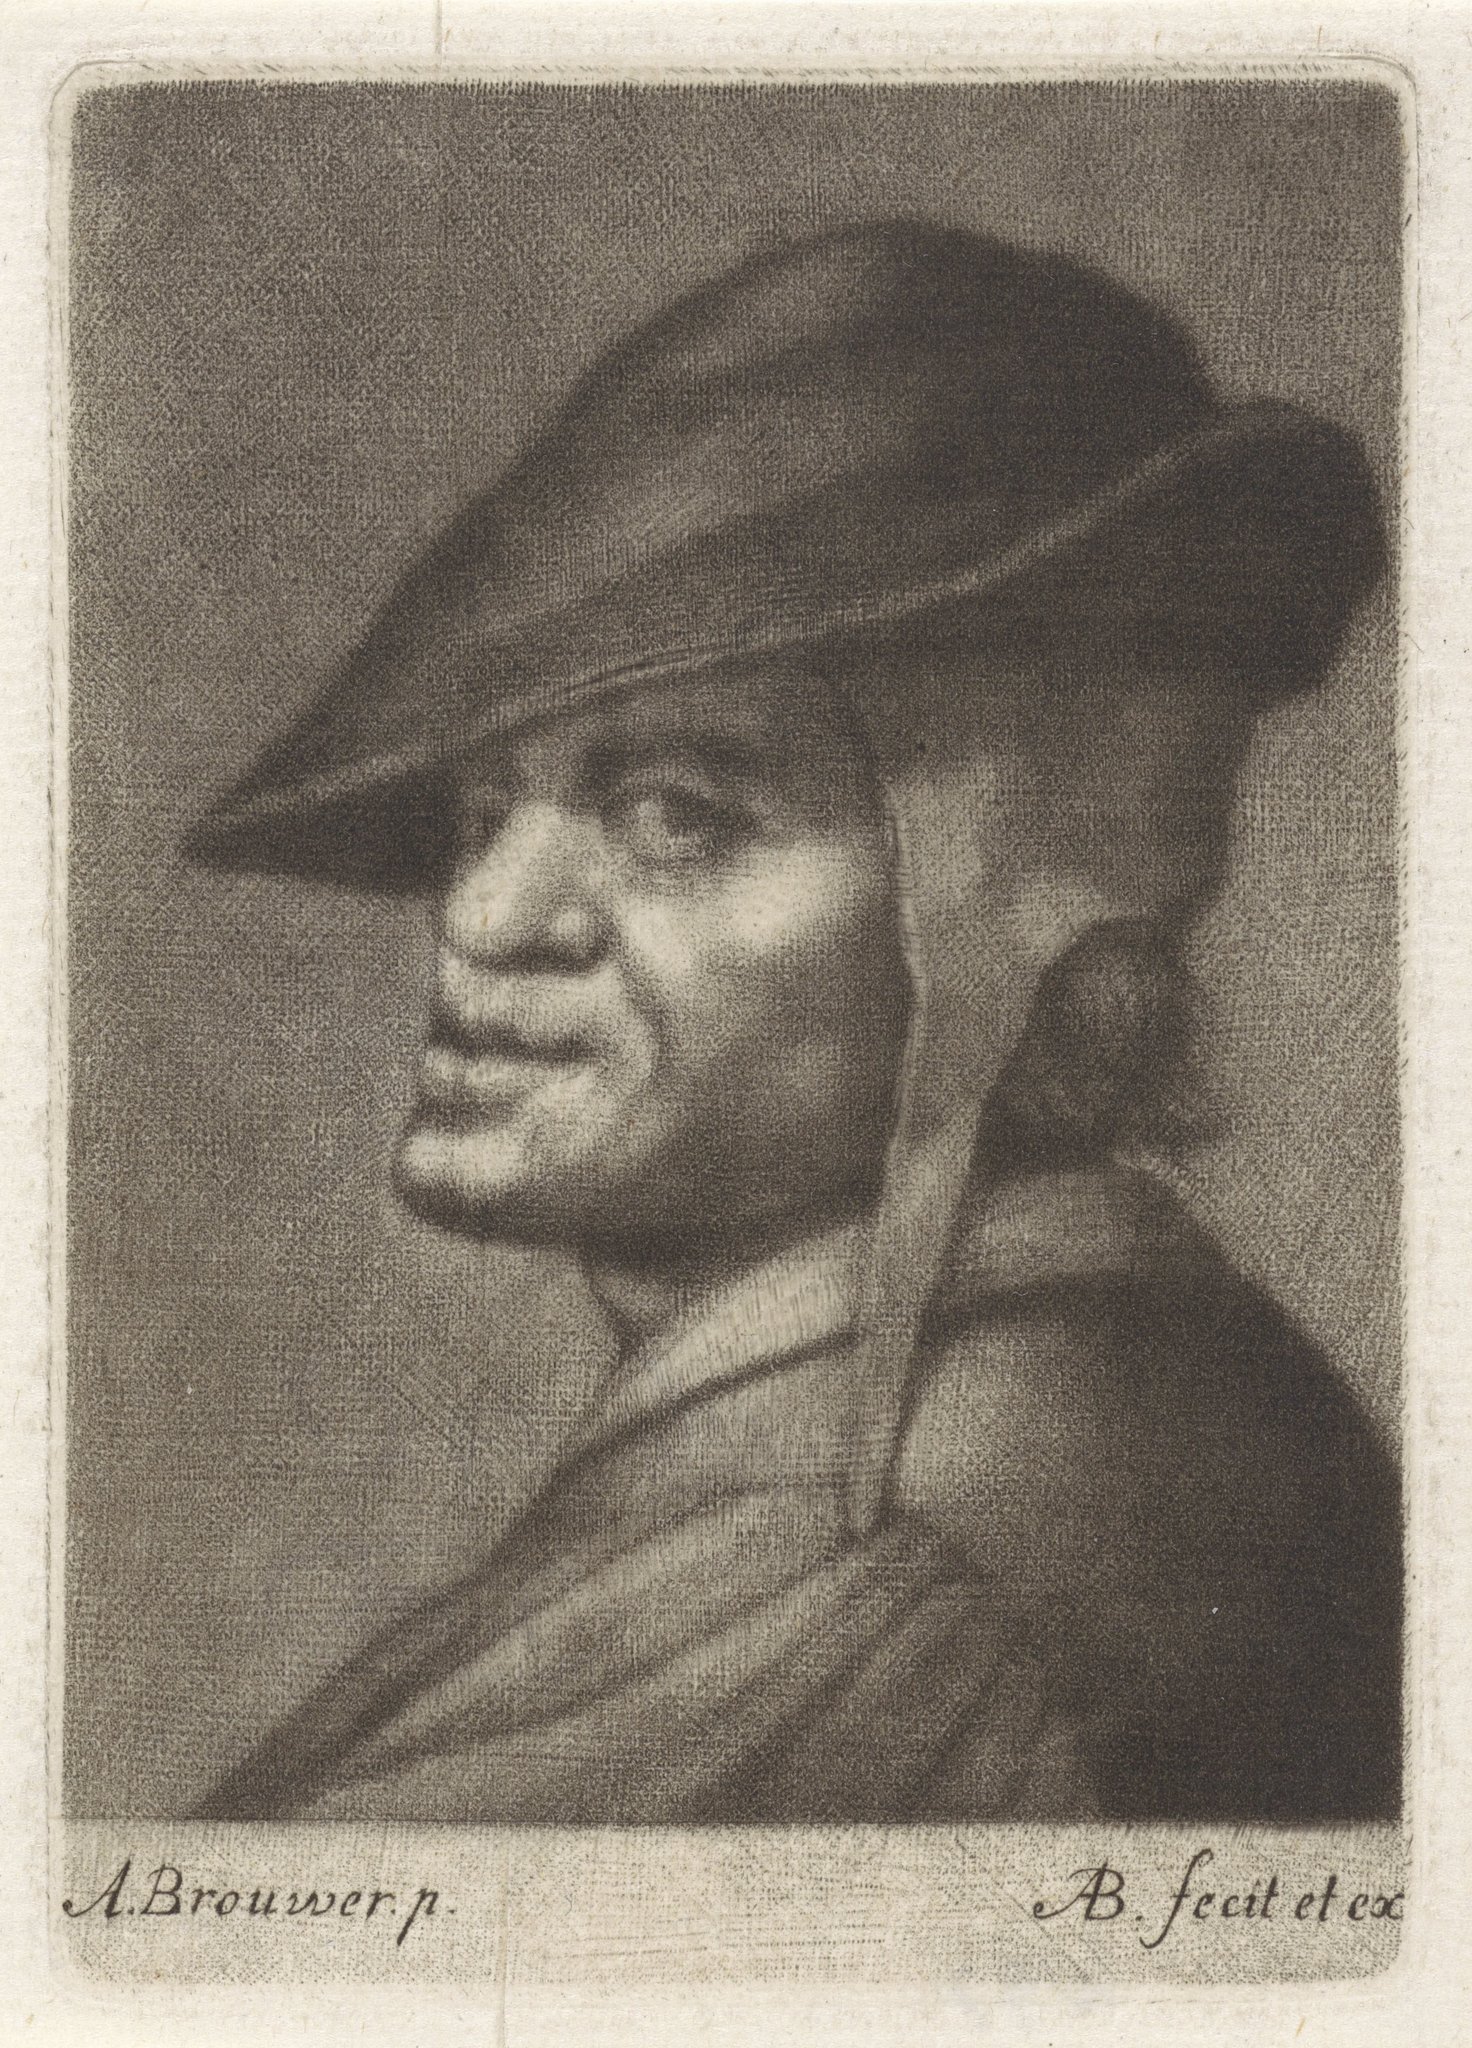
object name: print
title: Man met vilten PET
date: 1652-1690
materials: paper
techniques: engraving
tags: head-gear: cap (+ men's clothes)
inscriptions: collector's mark: Lugt 2228